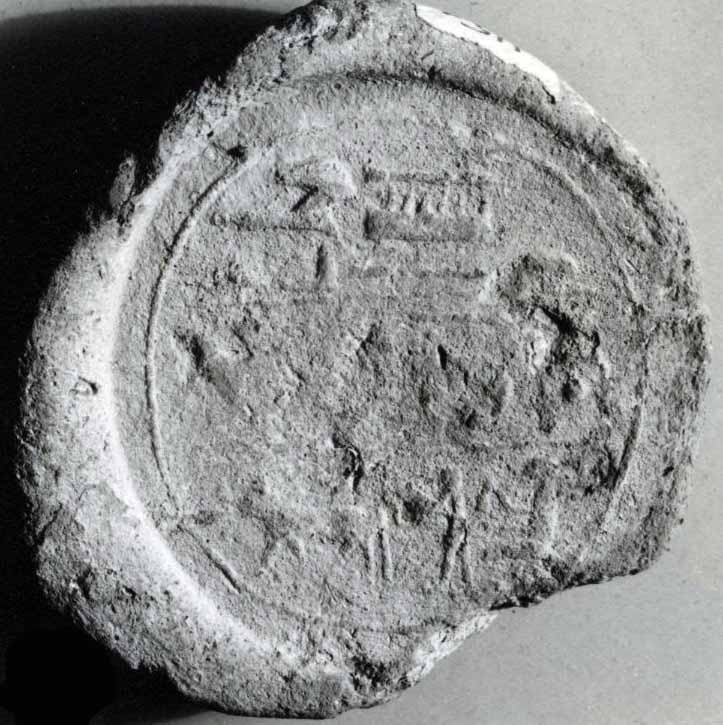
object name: cone of kanakht, scribe, circular impression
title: Funerary Cone of the Scribe Kanakht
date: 1550-1295 BCE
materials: pottery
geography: egypt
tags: hieroglyphs